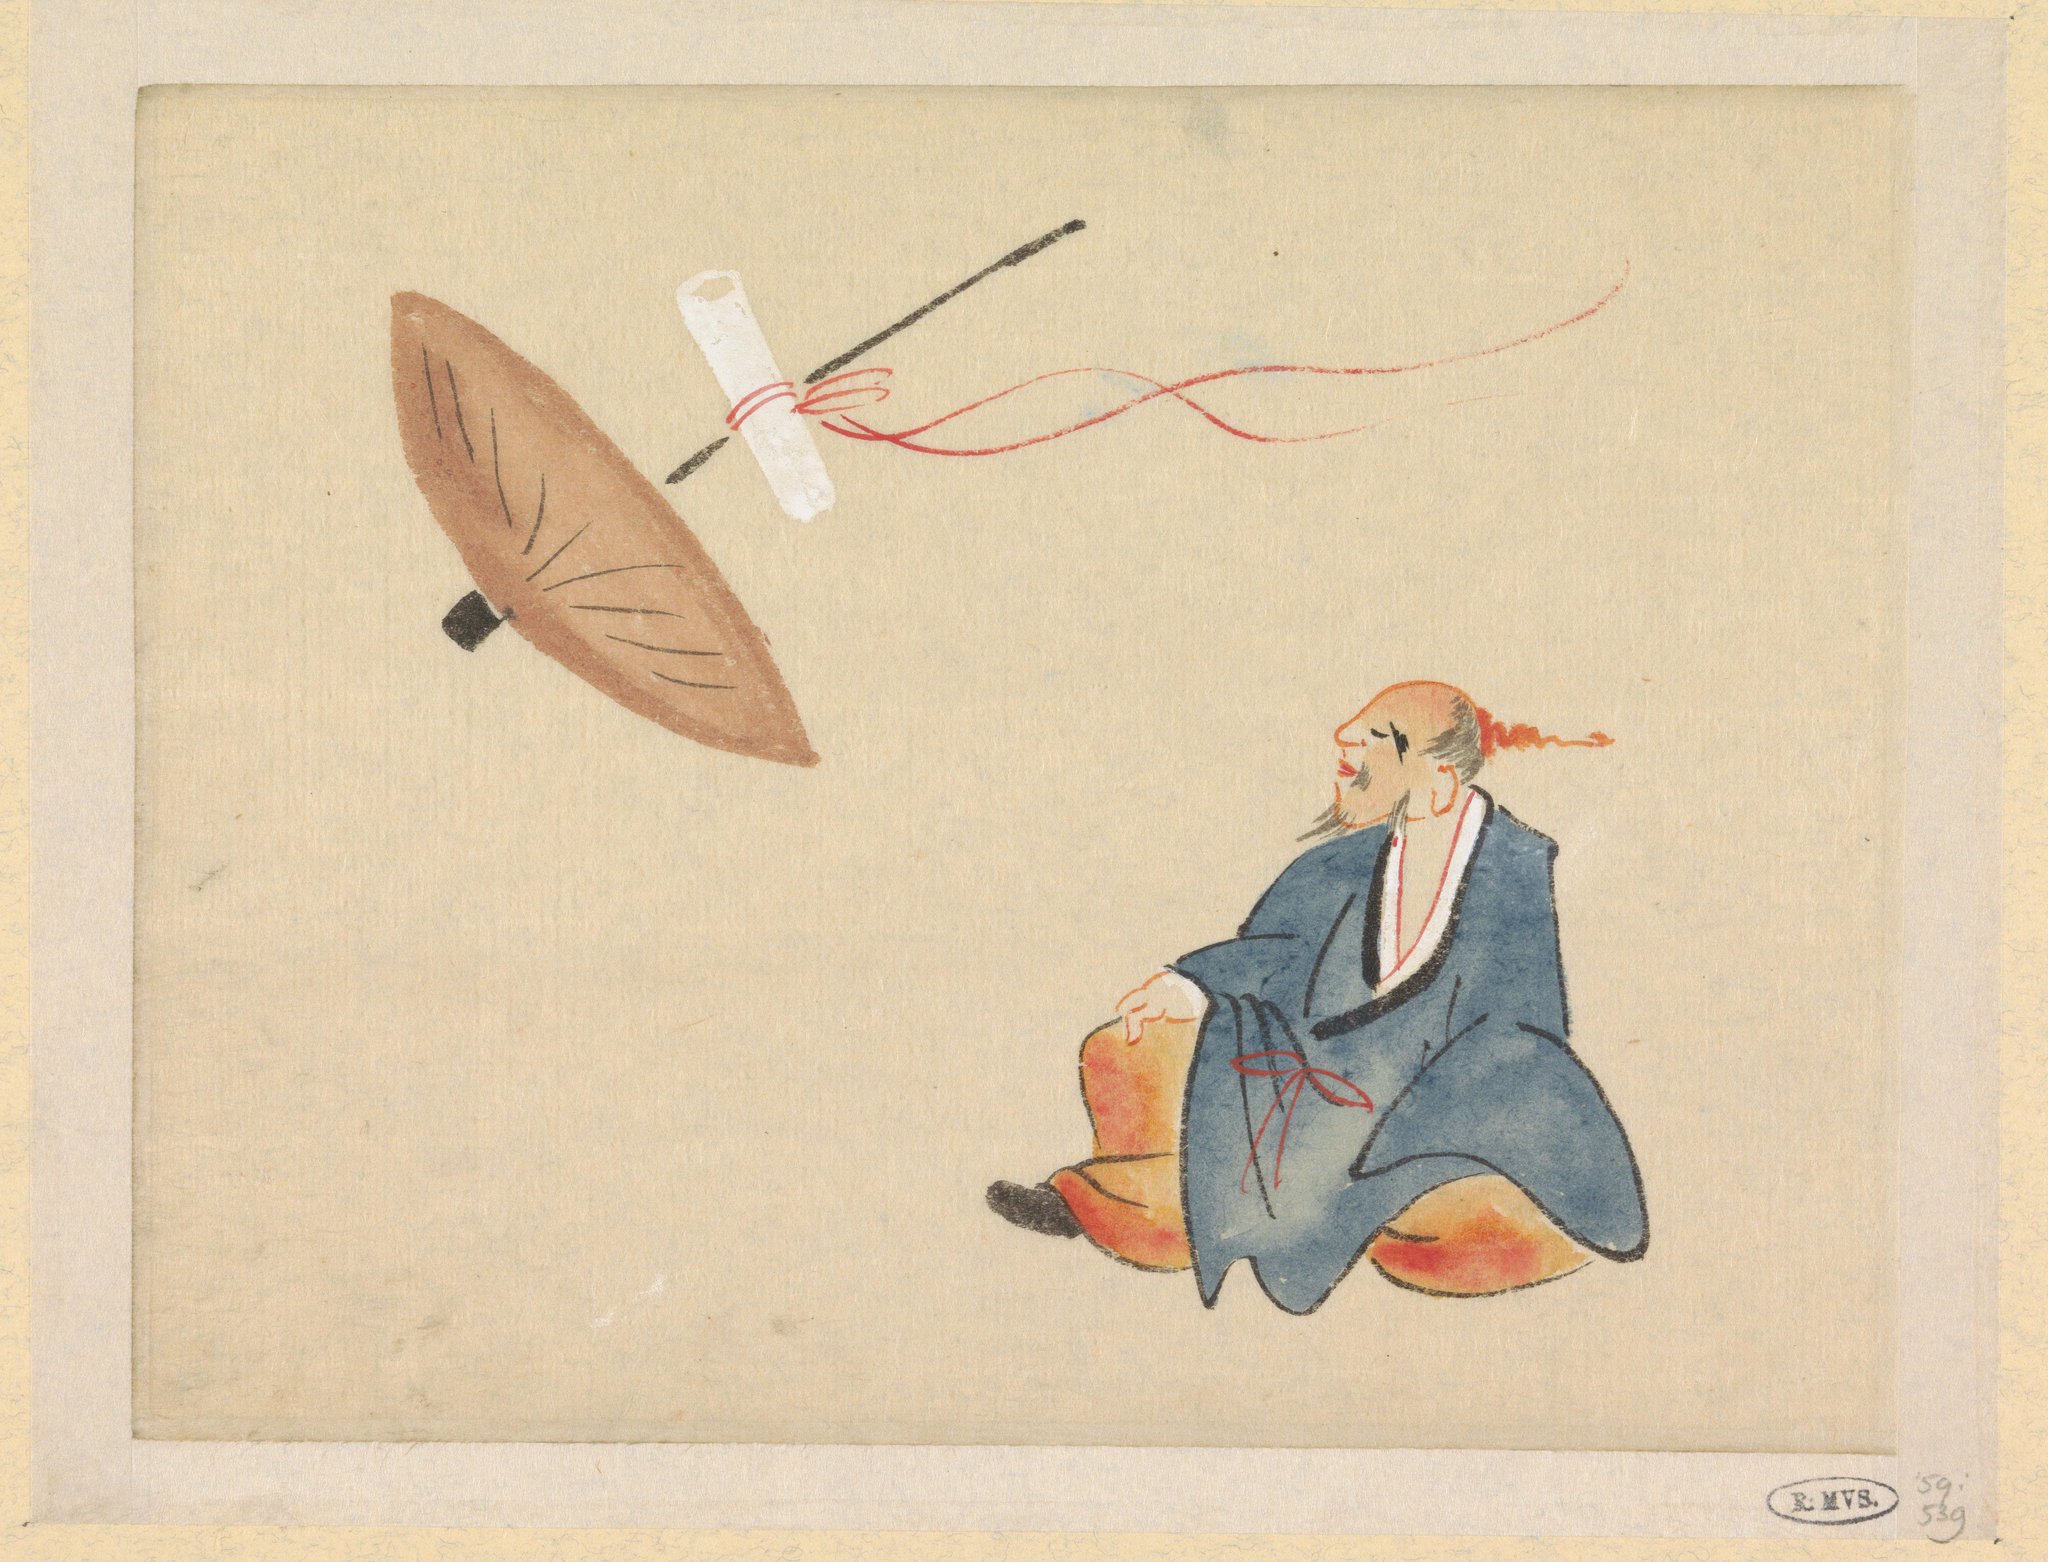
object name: watercolor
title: Zittende man bij wegvliegende parasol met brief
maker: Anonymous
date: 1800-1900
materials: paint, paper, watercolor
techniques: brush